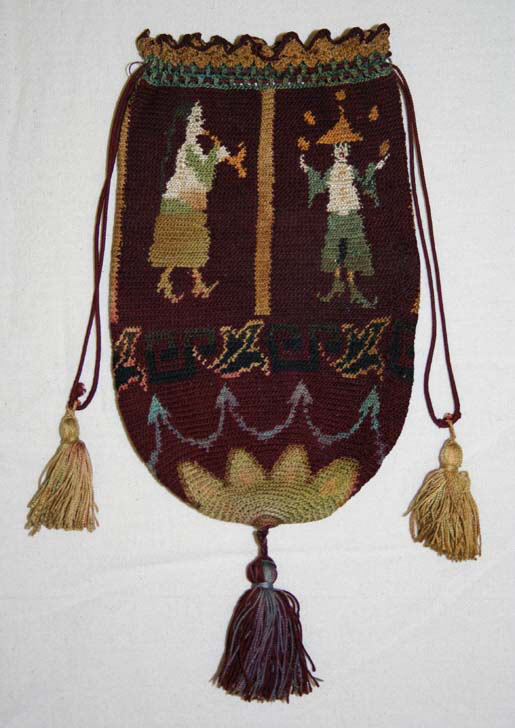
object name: pouch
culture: european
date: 1880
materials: silk